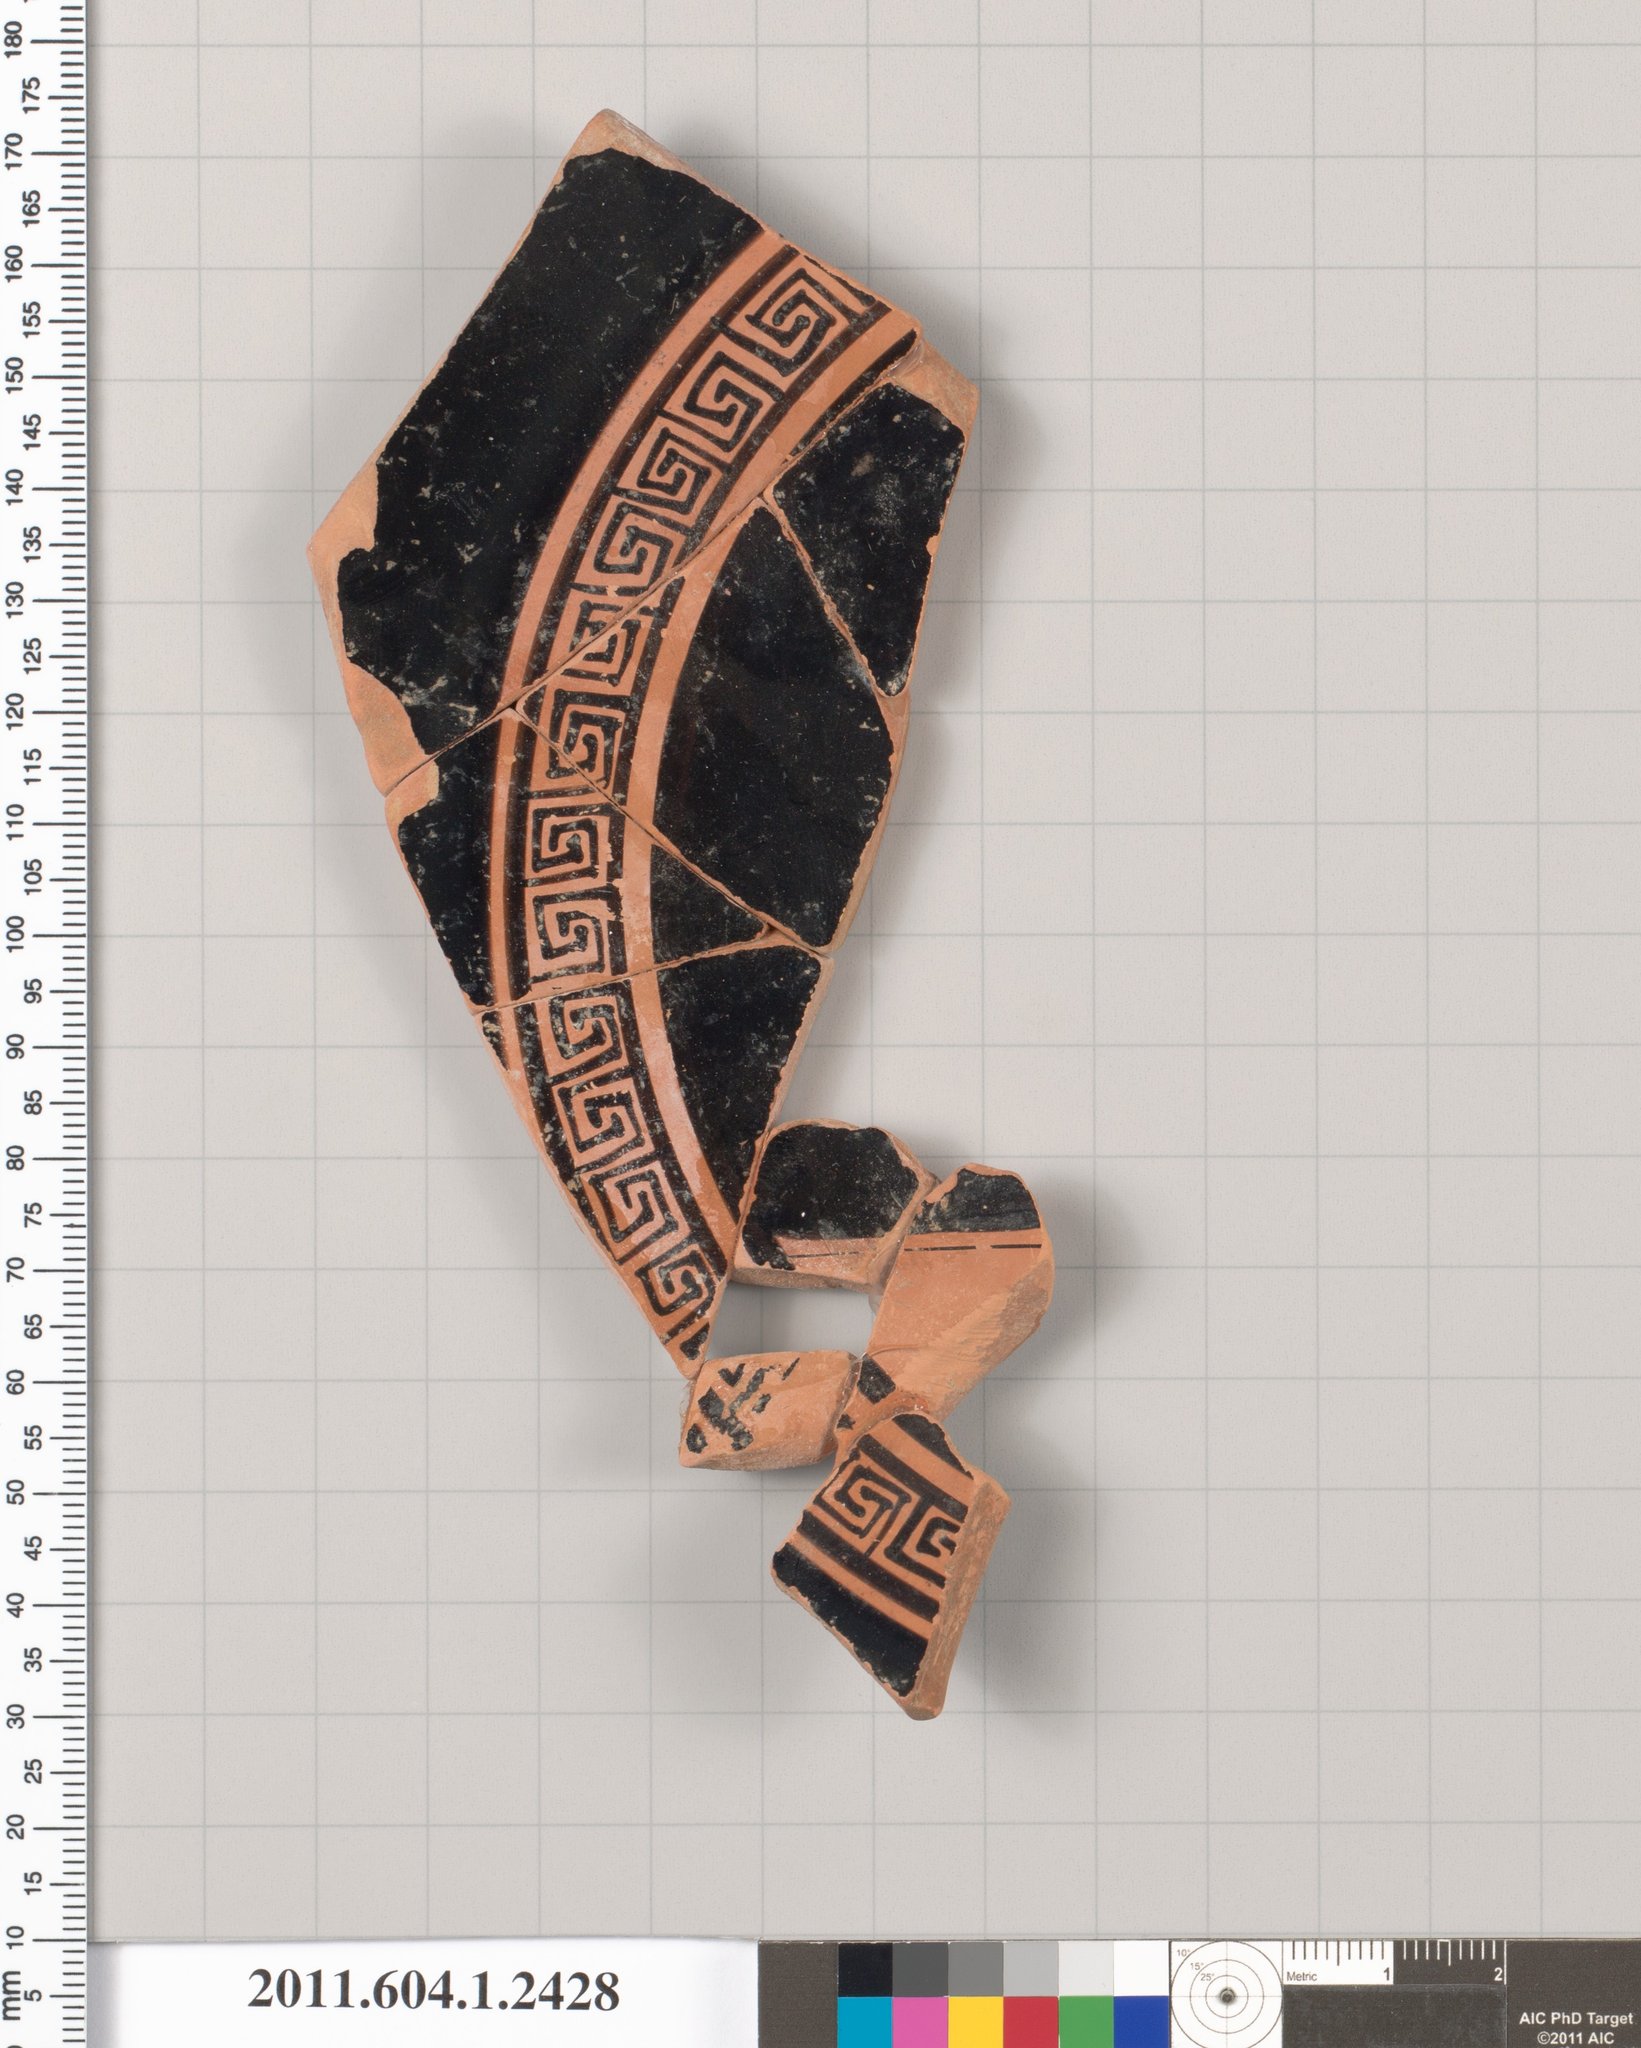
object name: kylix fragment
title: Terracotta fragment of a kylix (drinking cup)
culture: greek, attic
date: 490-480 BCE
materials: terracotta